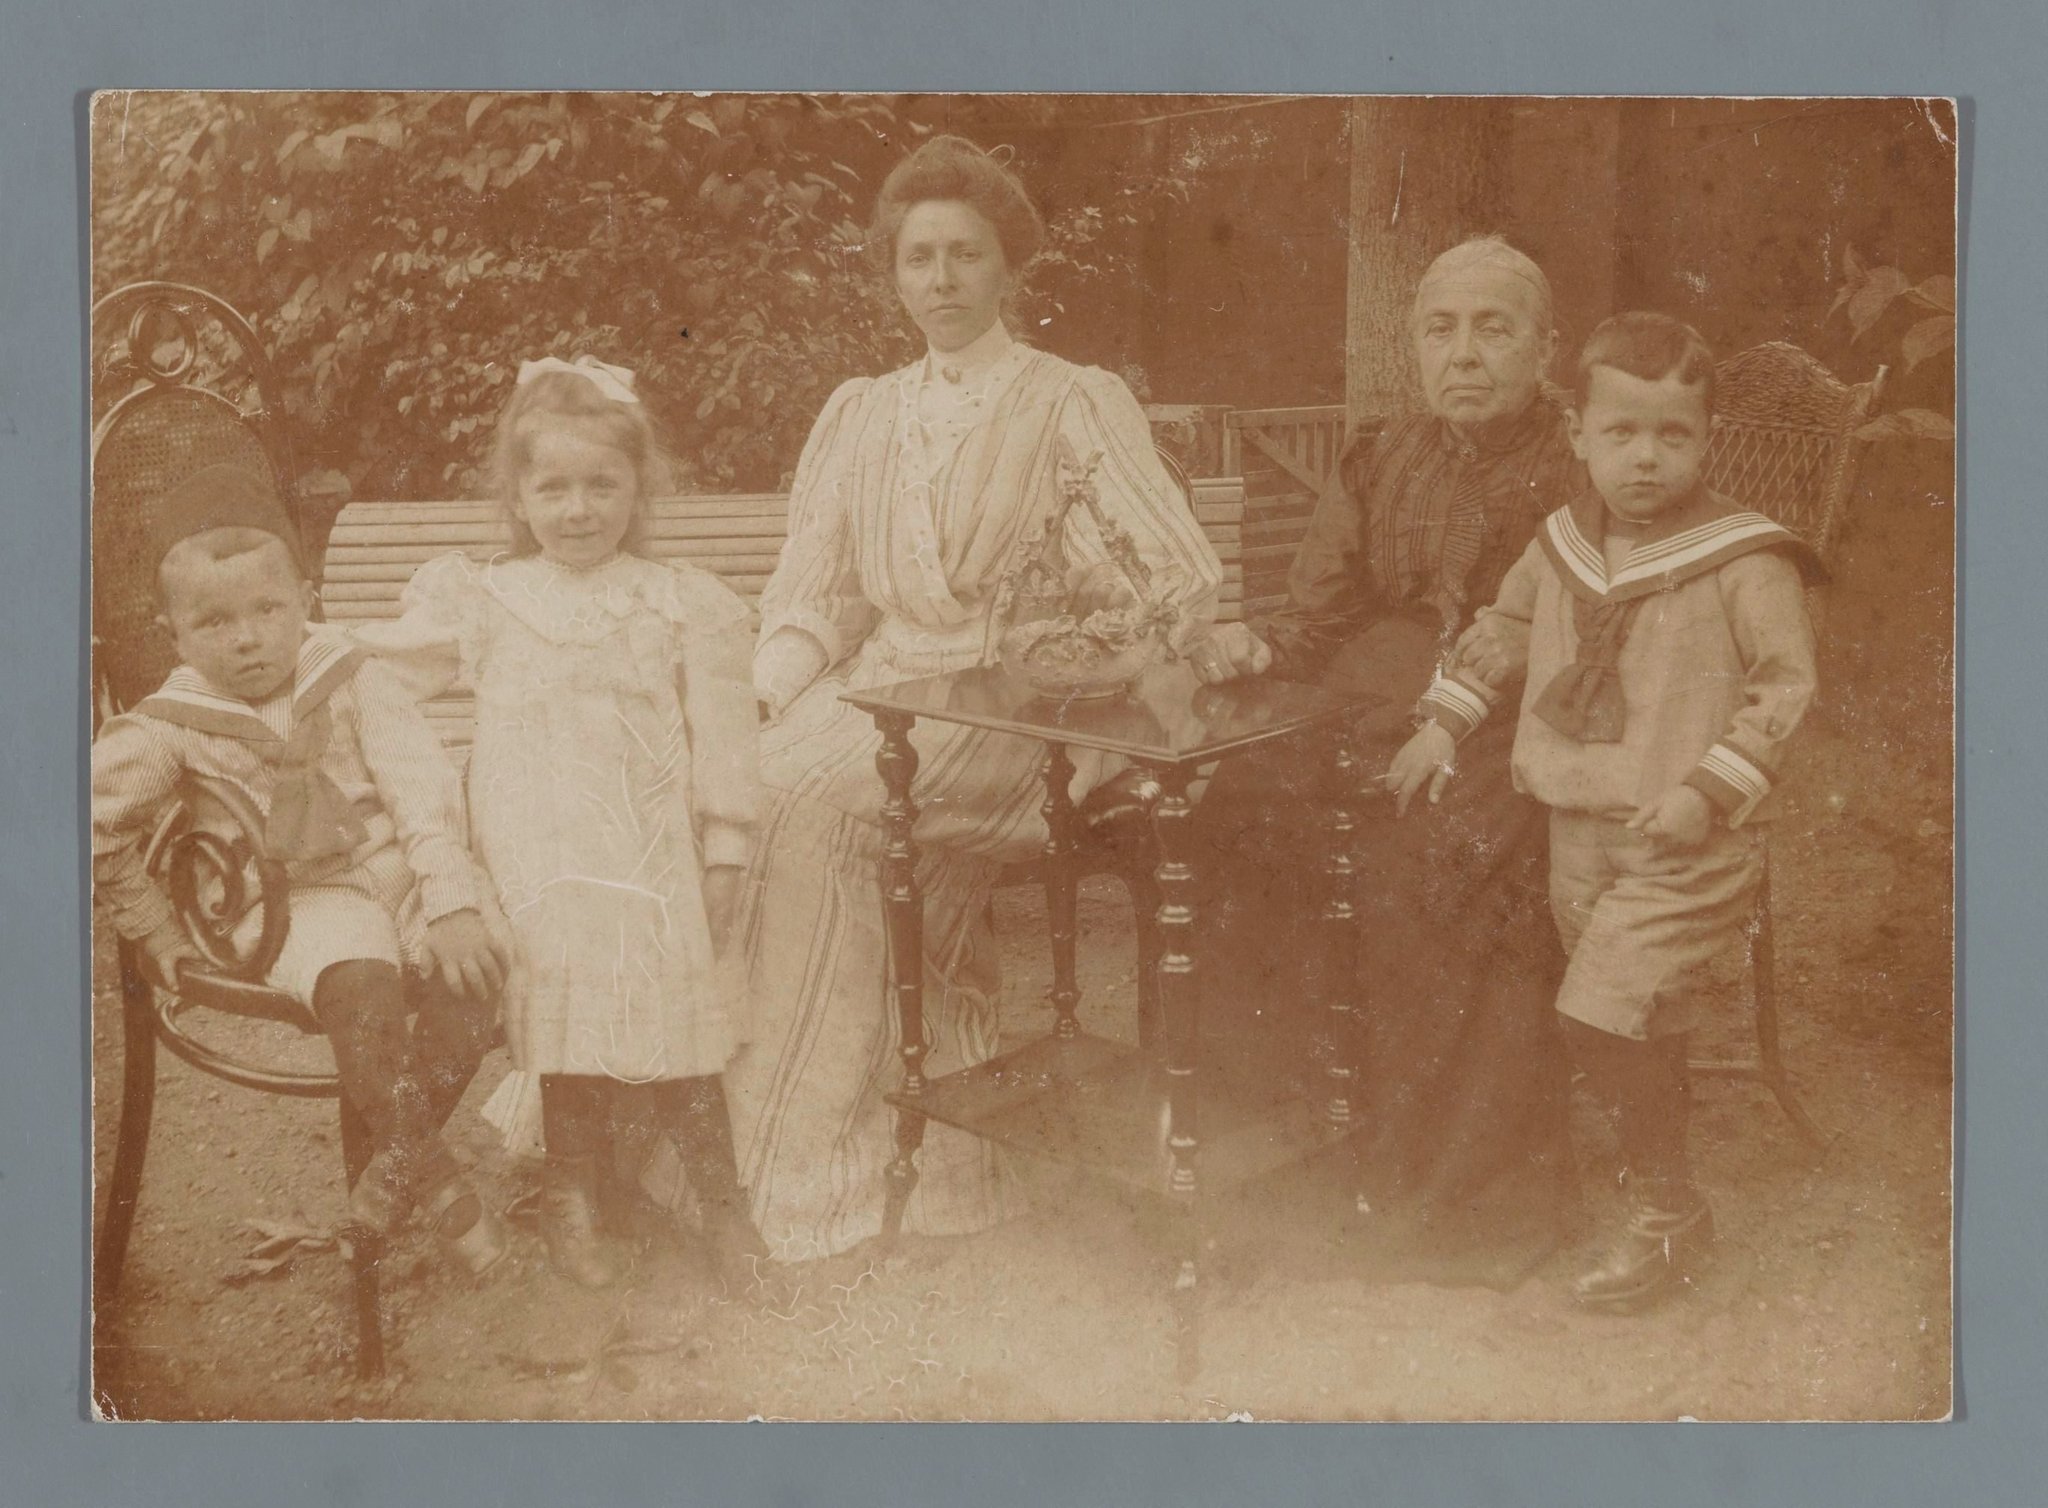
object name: photograph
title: Groepsportret van Wilhelmina Gerarda Hoogendijk met haar kinderen en moeder in een tuin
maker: Anonymous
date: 1900-1905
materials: photographic support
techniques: albumen print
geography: schoonhoven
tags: amsterdam, painter, sculptor, adrianus johannes van der kop (ad), draughtsman, family group, especially parents with their child(ren)